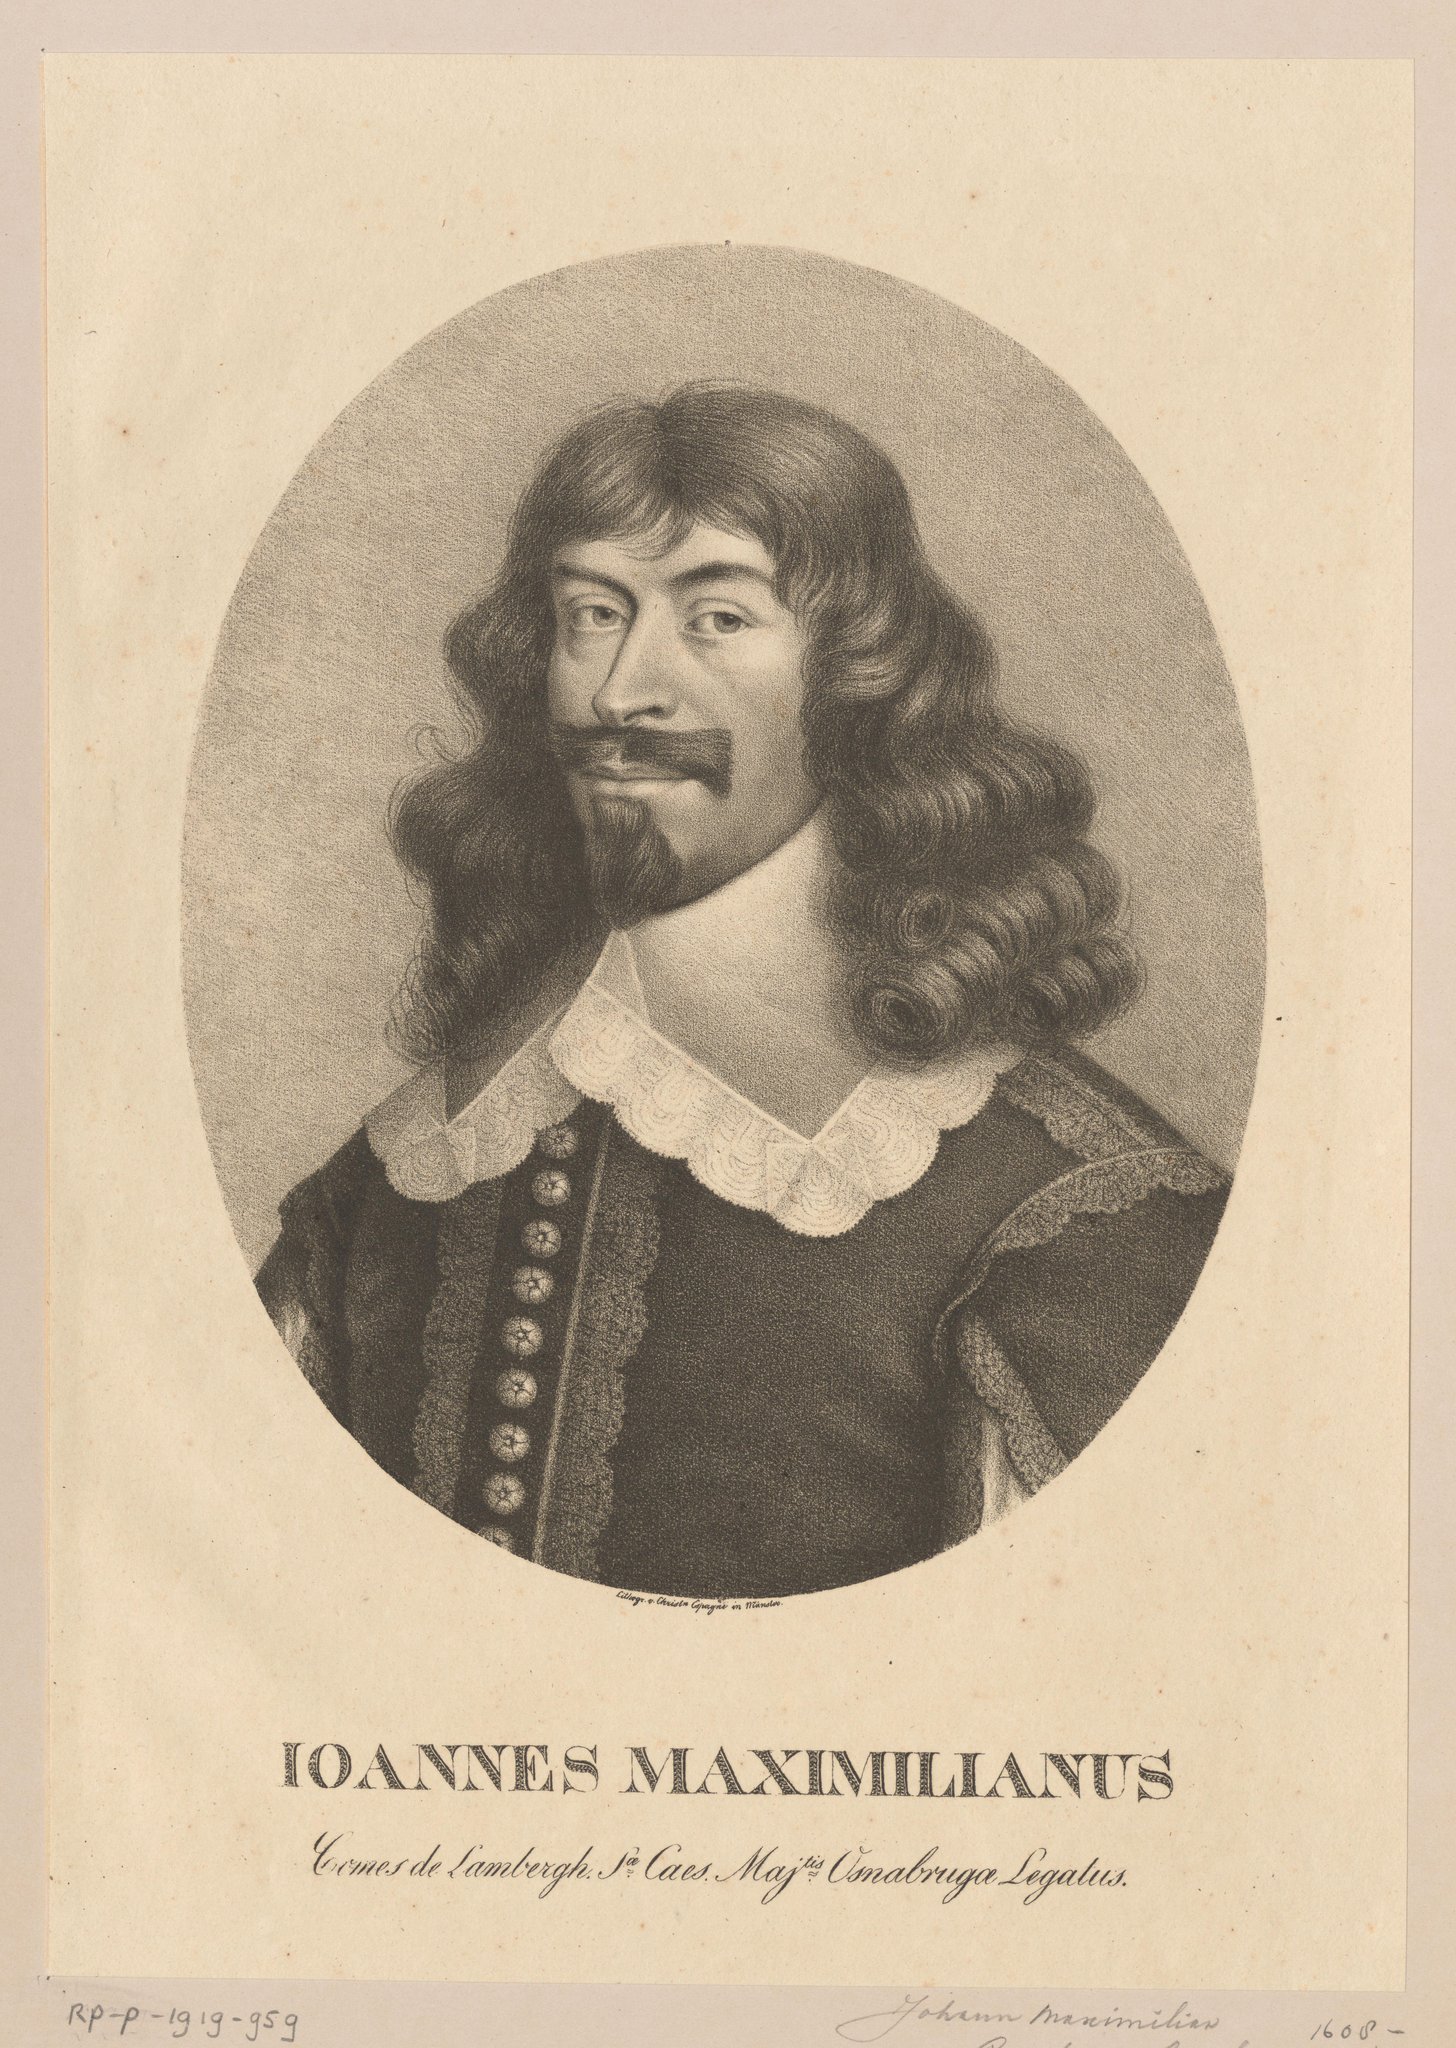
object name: print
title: Portret van Johann Maximilian van Lamberg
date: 1824-1827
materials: paper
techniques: lithograph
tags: vienna, historical persons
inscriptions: collector's mark: Lugt 2228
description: Prent waarschijnlijk uit: Bildnisse der beim westfälischen Friedensschluß zu Münster und Osnabrück versammelt gewesenen Gesandten. Münster: Christian Espagne, [1824-1827]. Deze publicatie bevat een onbekend aantal lithografieën, die in afleveringen verschenen als illustratie bij de tekst.